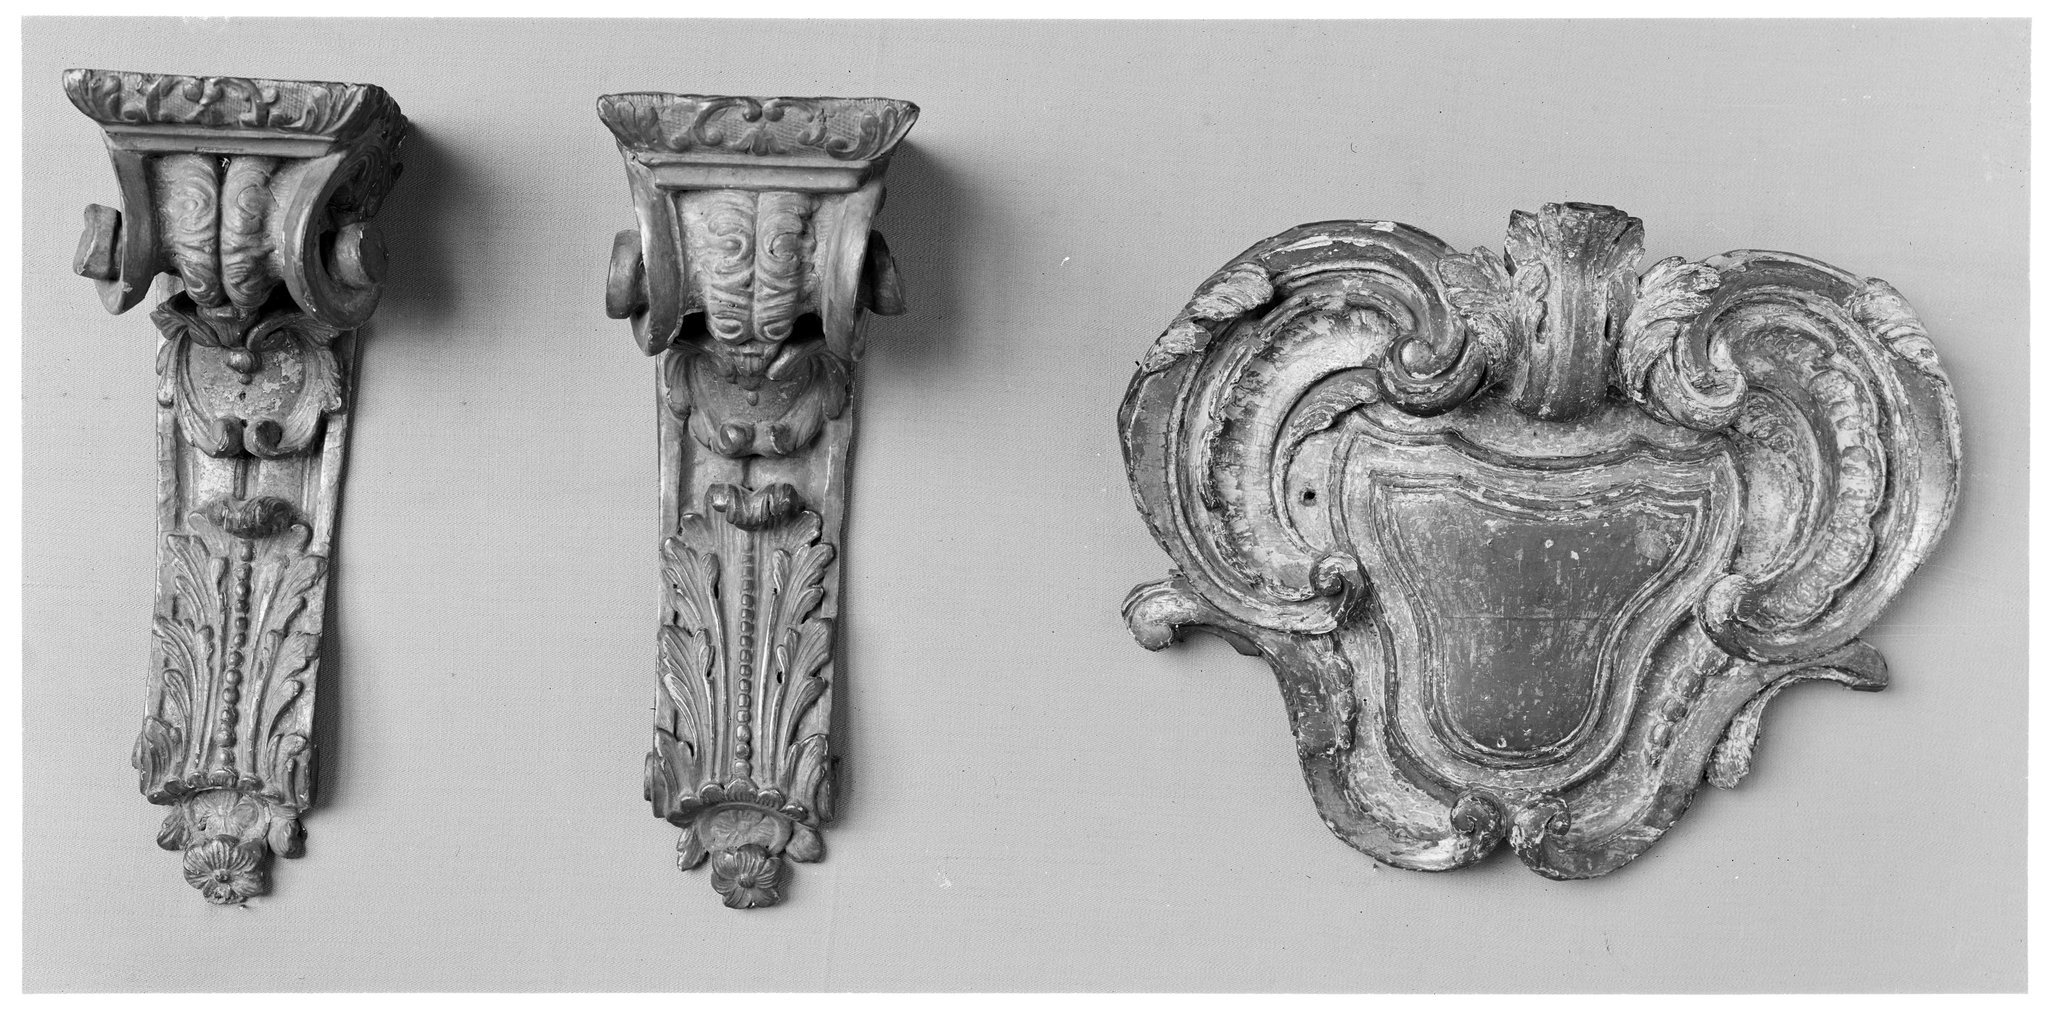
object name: console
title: Pair of consoles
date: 1601-1700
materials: wood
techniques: carving, gilding